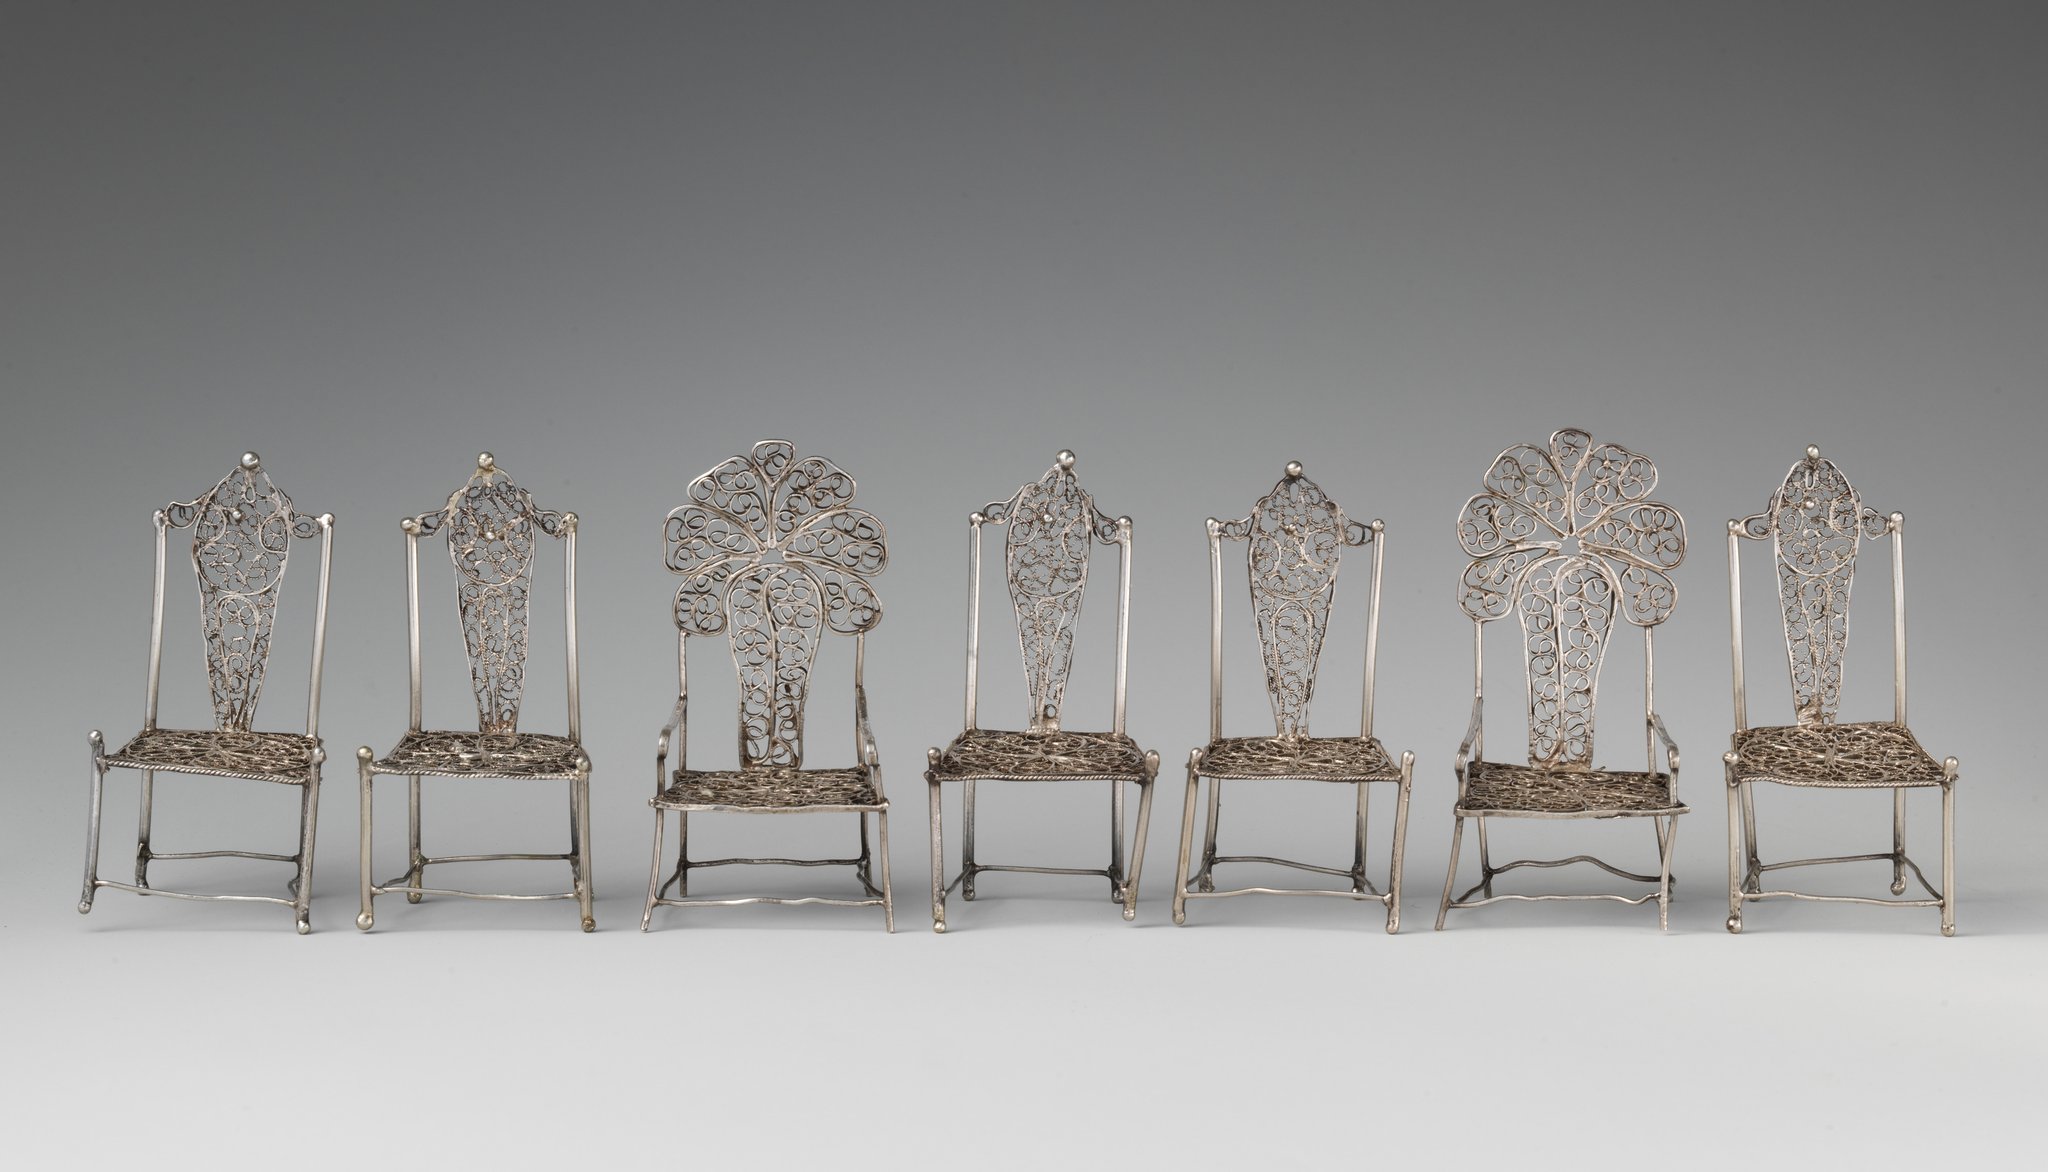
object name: chair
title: Set of seven miniature chairs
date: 1801-1900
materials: silver